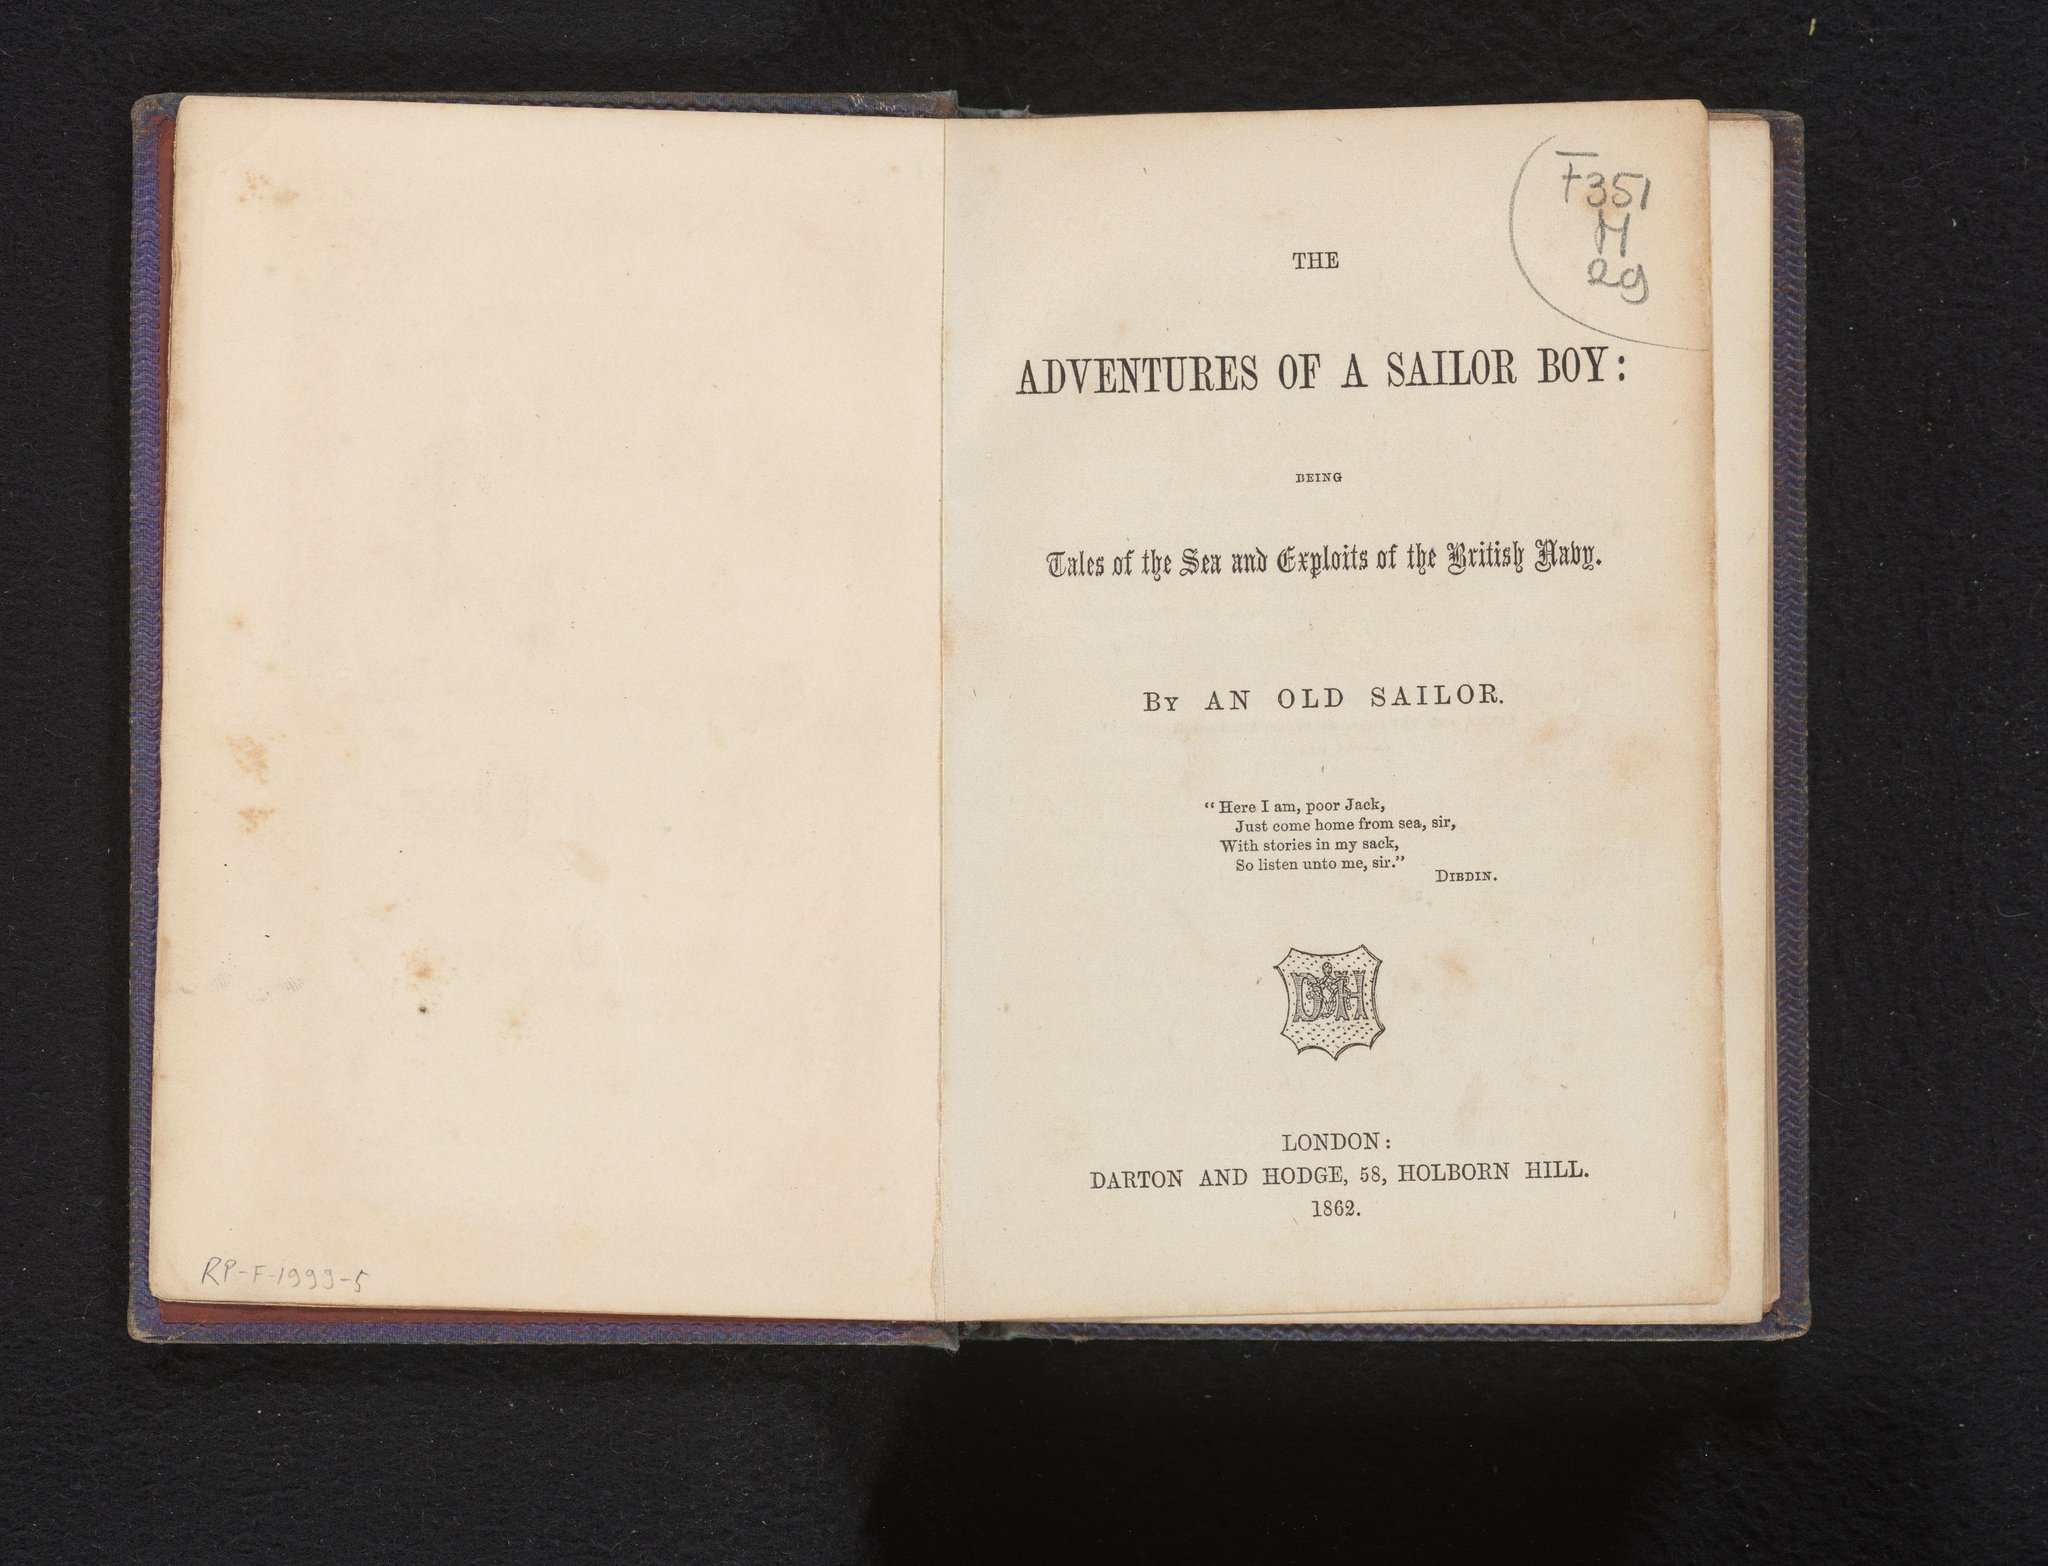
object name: book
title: The adventures of a sailor boy : being tales of the sea and exploits of the British navy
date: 1862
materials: cardboard, leather, paper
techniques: albumen print, chromolithography, printing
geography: london